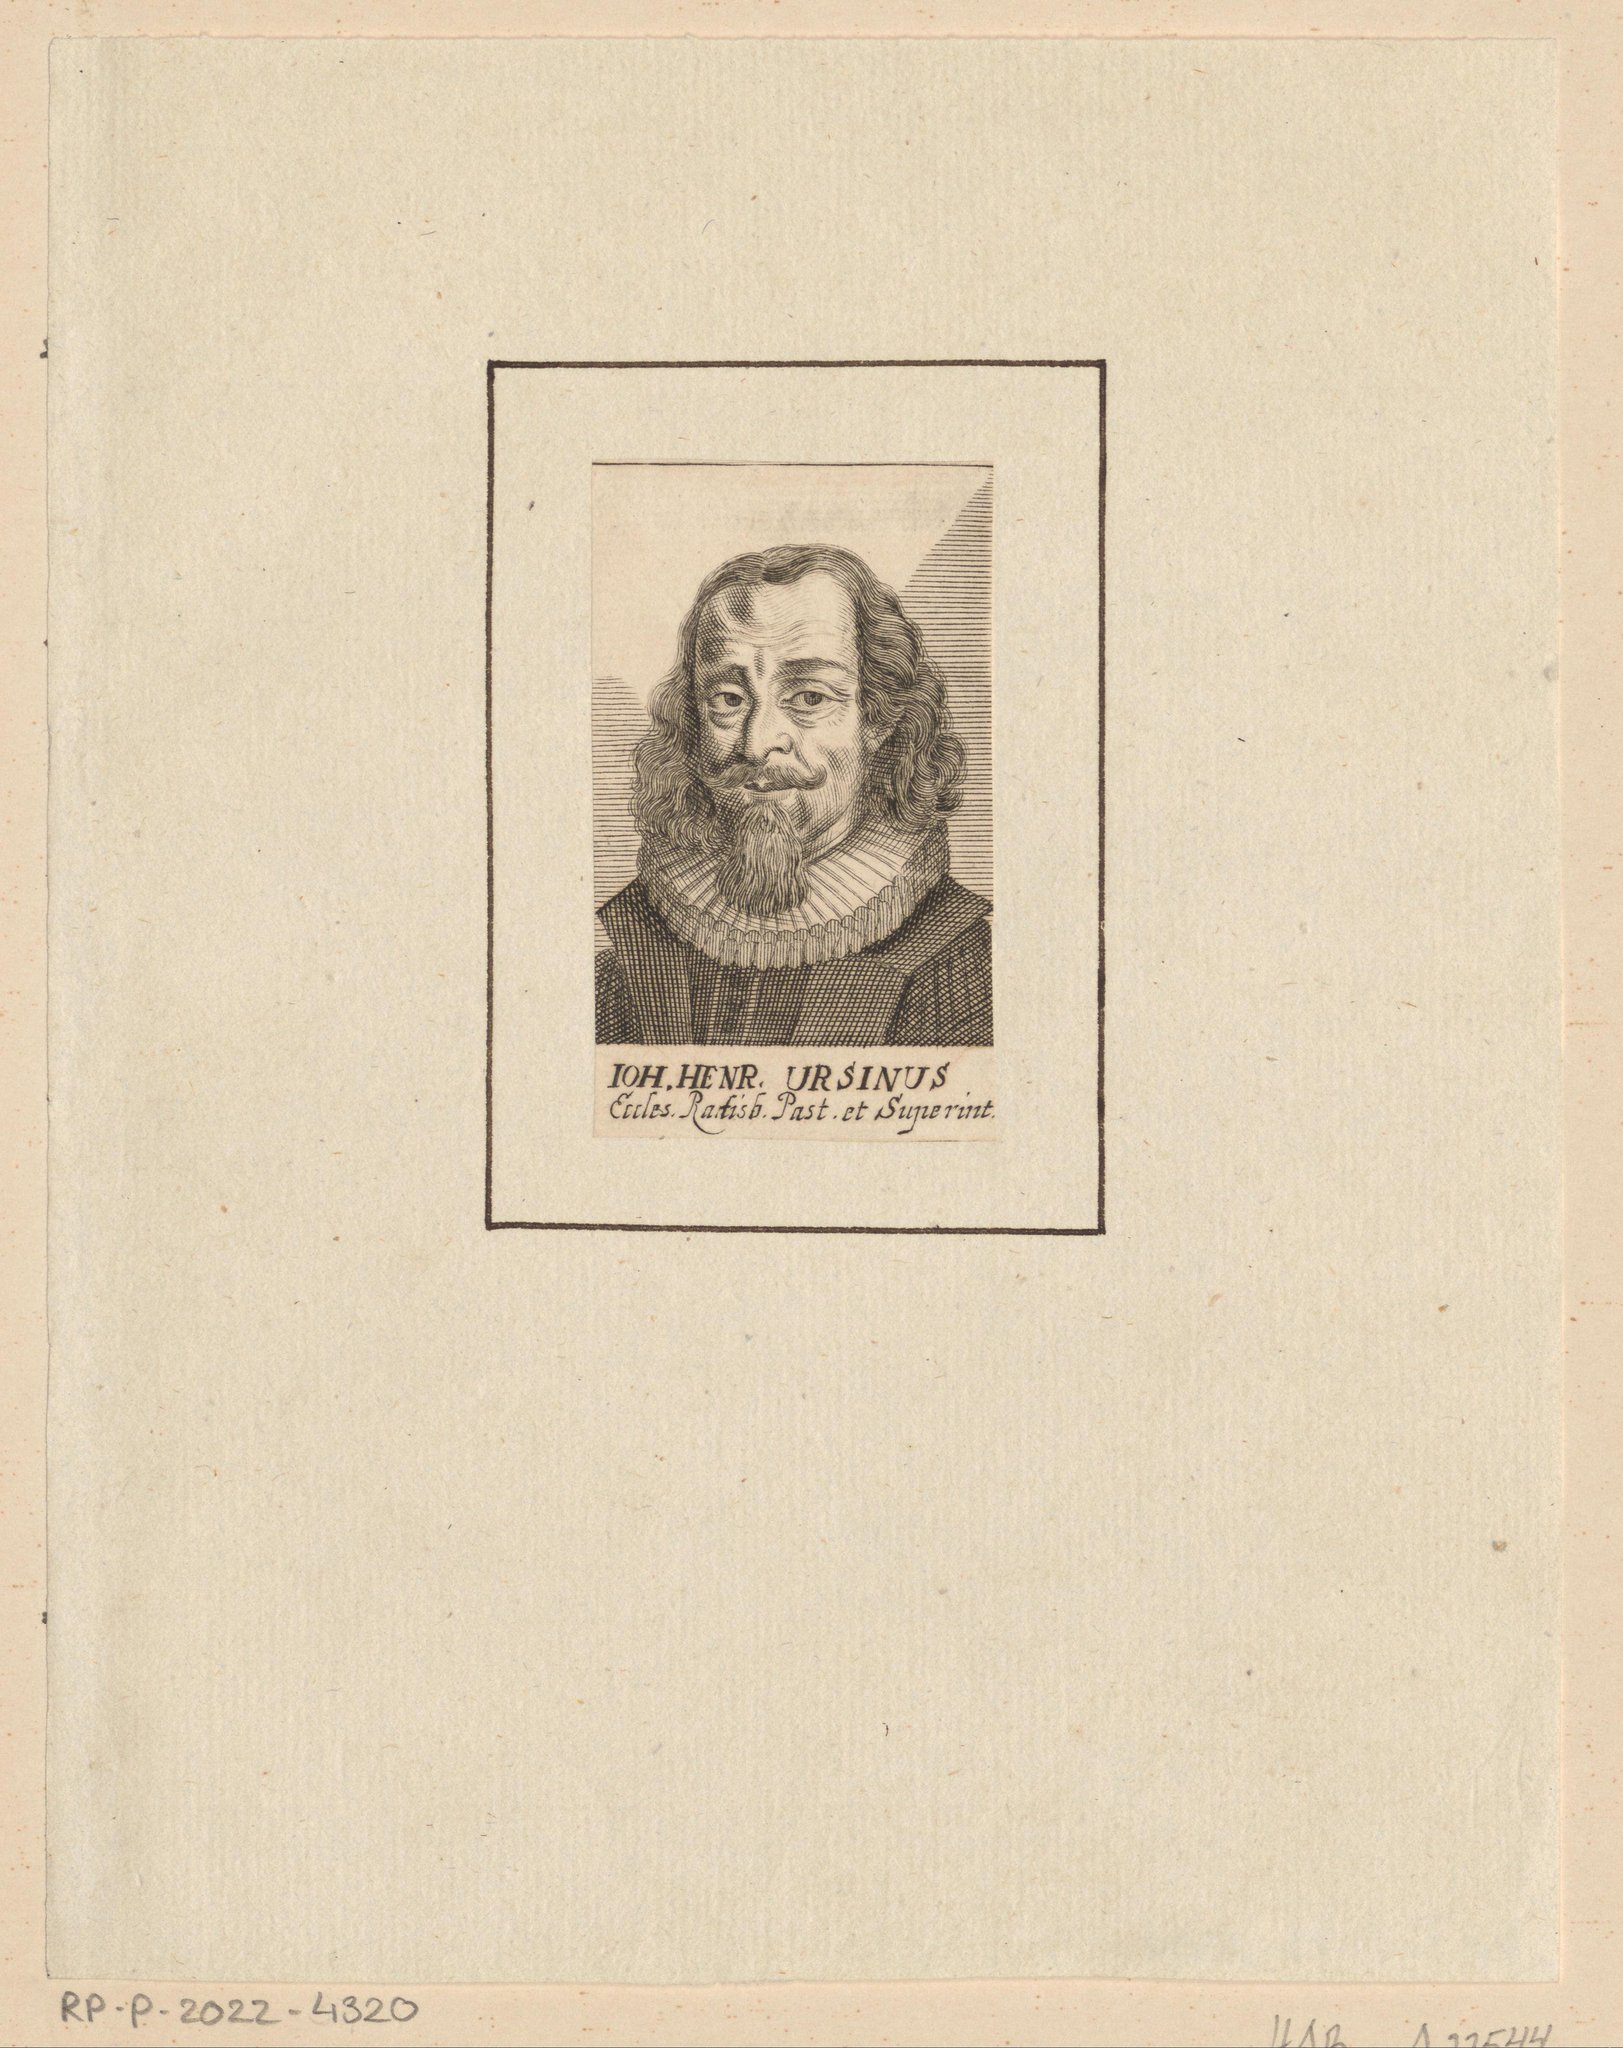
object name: book illustration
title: Portret van Johann Heinrich Ursinus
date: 1688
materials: paper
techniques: engraving, etching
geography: nuremberg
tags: theologian, historical persons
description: Prent uit: Freher, Paul. Theatrum virorum eruditione clarorum. Neurenberg: Johann Hoffmann, 1688.